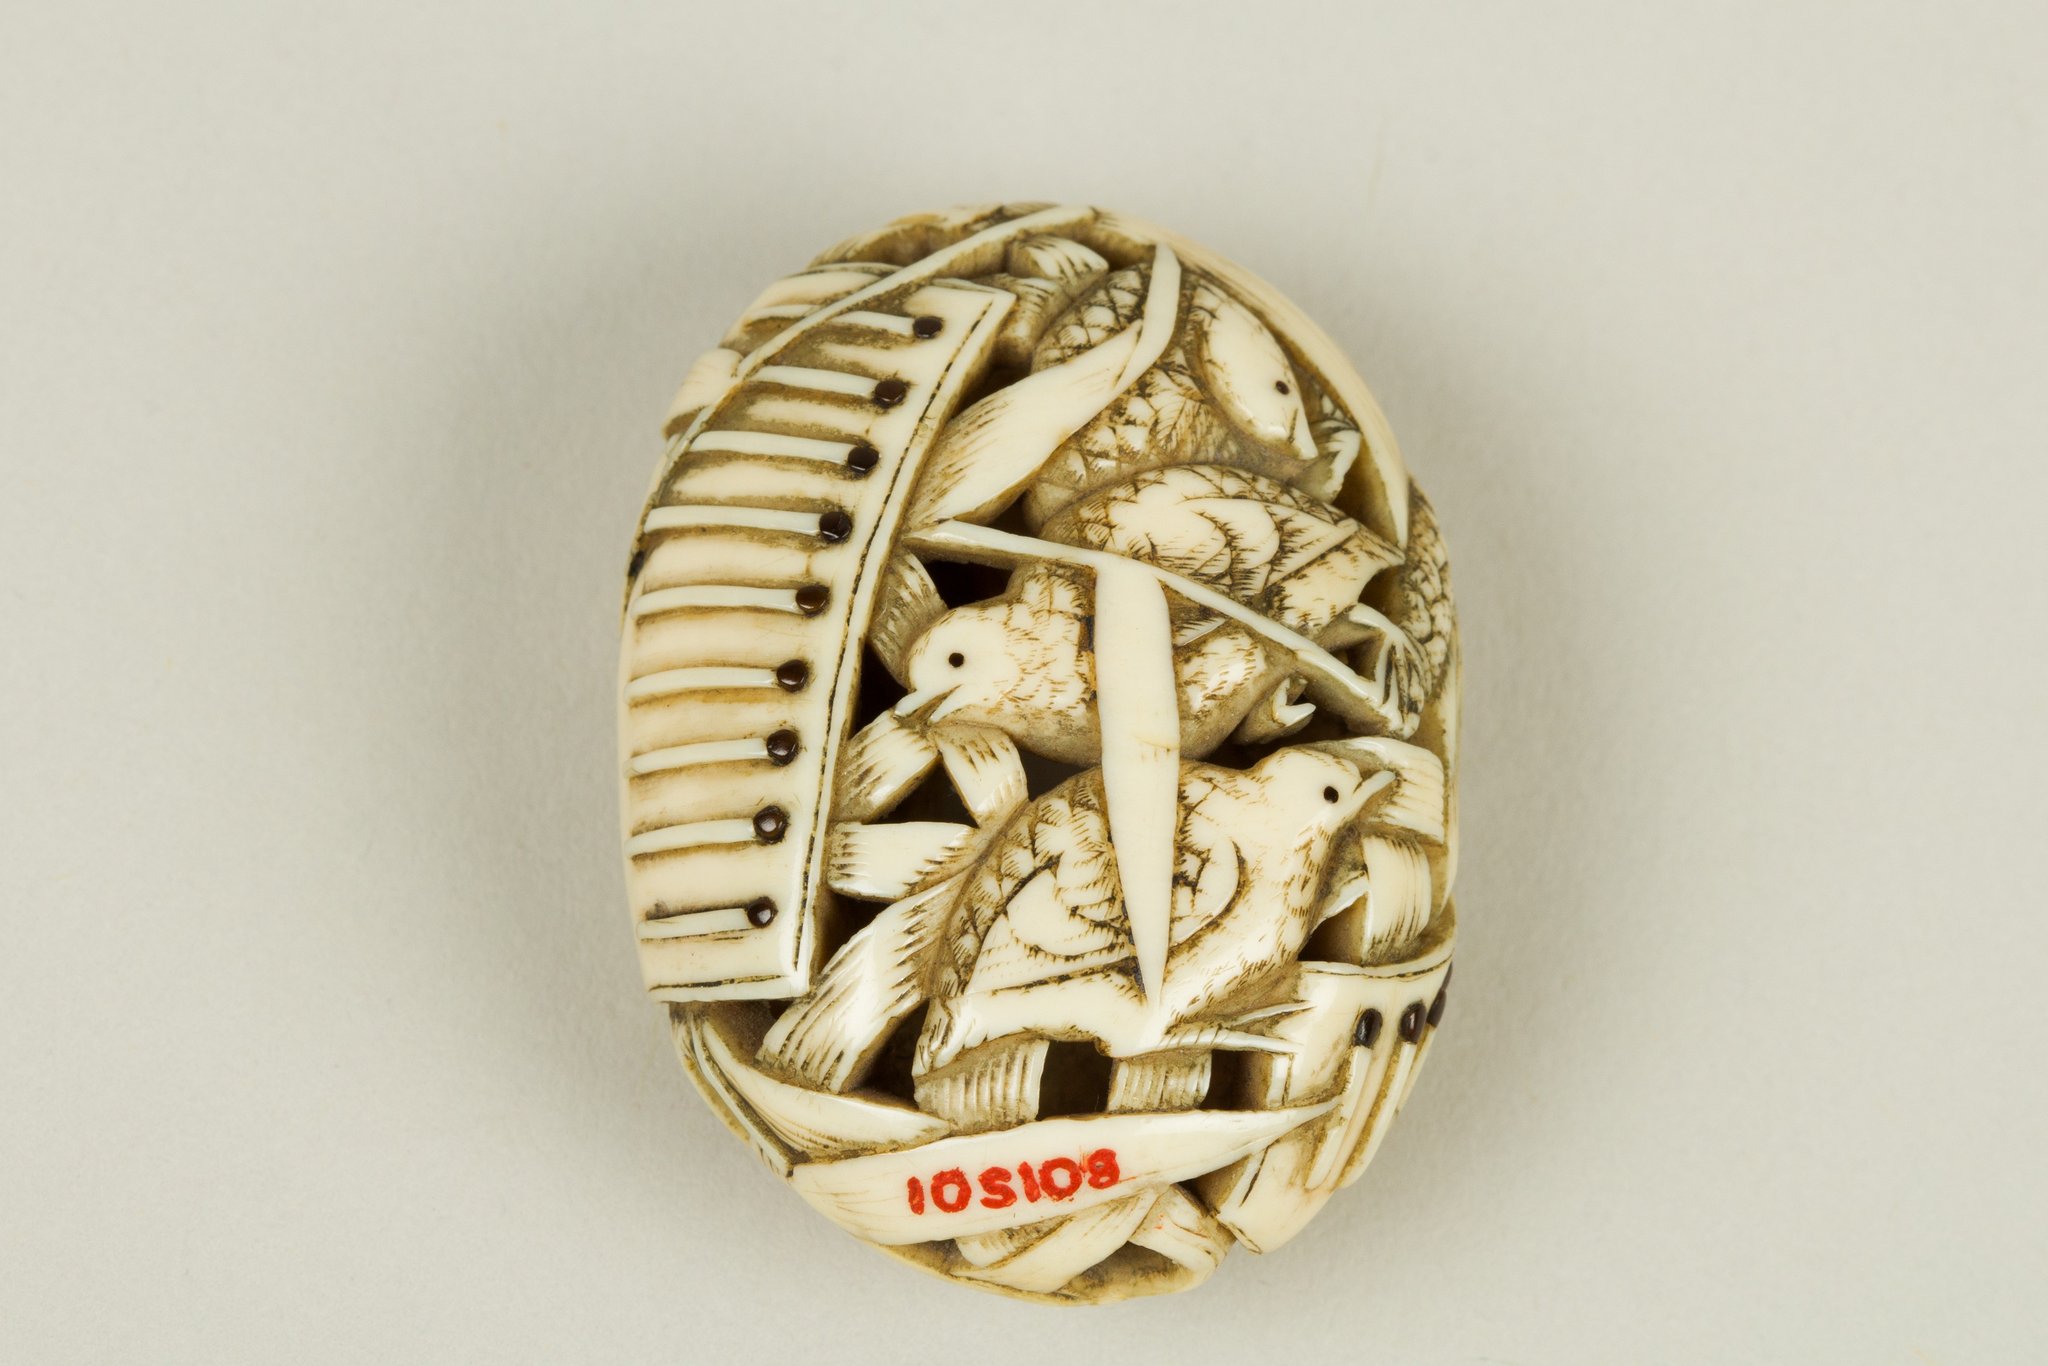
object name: netsuke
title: Netsuke of Quail and Millet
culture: japanese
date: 1801-1900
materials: ivory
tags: birds